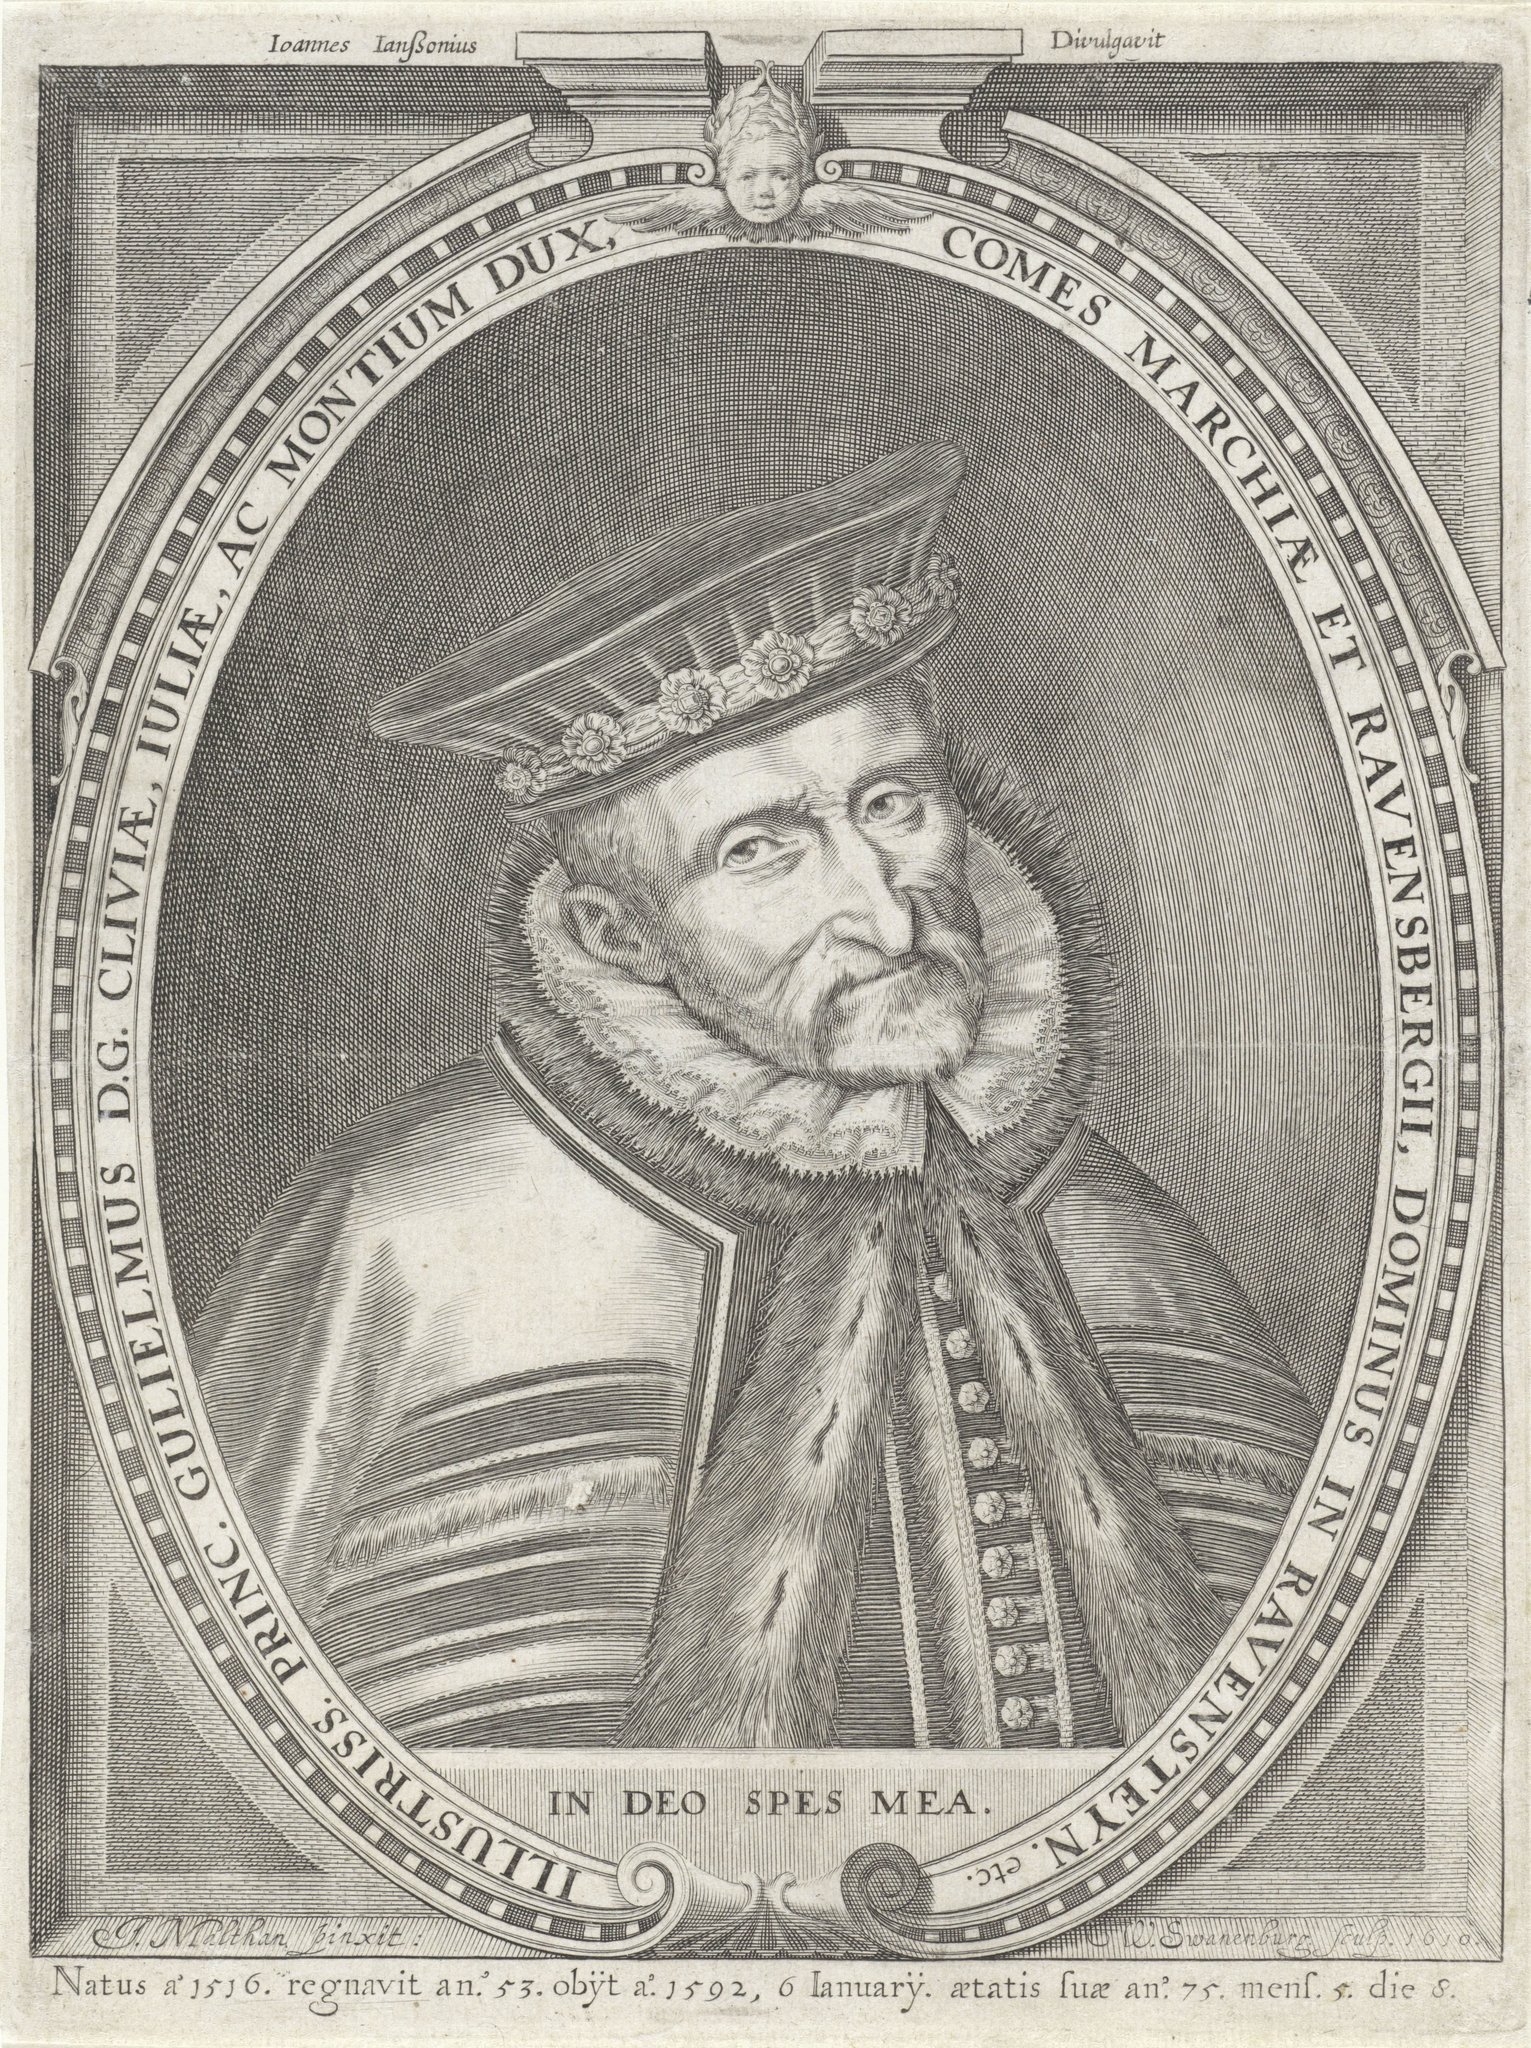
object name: print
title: Portret van Willem V, hertog van Gulik, Kleef en Berg en graaf van Mark en Ravensberg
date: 1610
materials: paper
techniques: engraving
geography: amsterdam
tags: düsseldorf, hertog, willem v (hertog van gulik, kleef en berg, graaf van mark en ravensberg)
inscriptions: collector's mark: Lugt 2228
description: Portret van Willem V, hertog van Gulik, Kleef en Berg en graaf van Mark en Ravensberg, in mantel met bontrand en een baret op het hoofd.